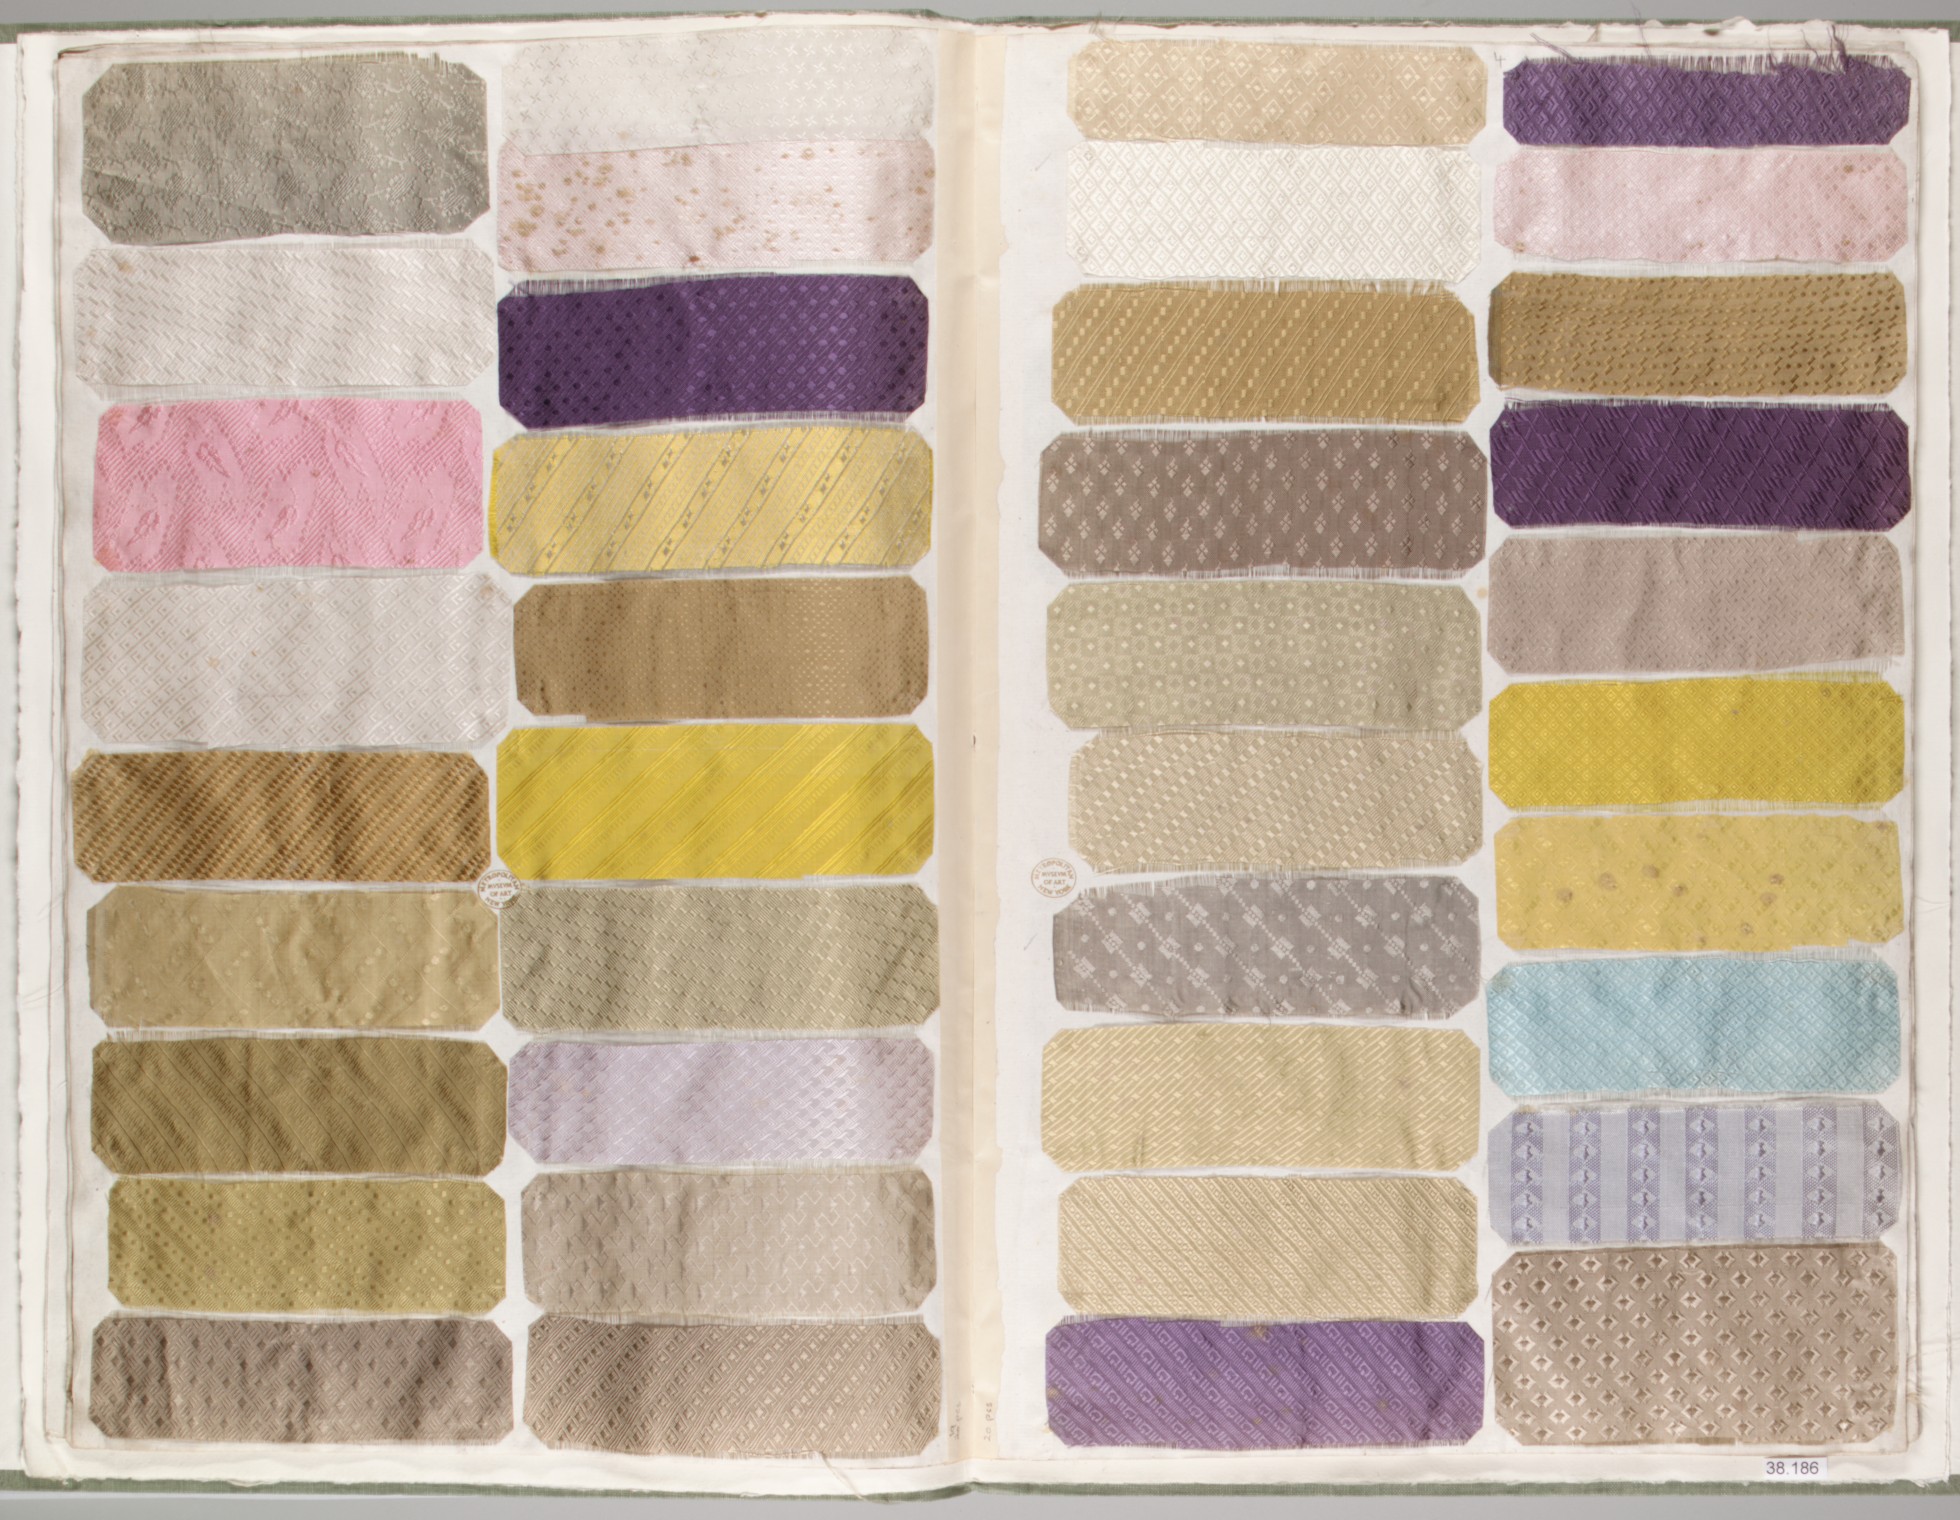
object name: sample book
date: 1867-1900